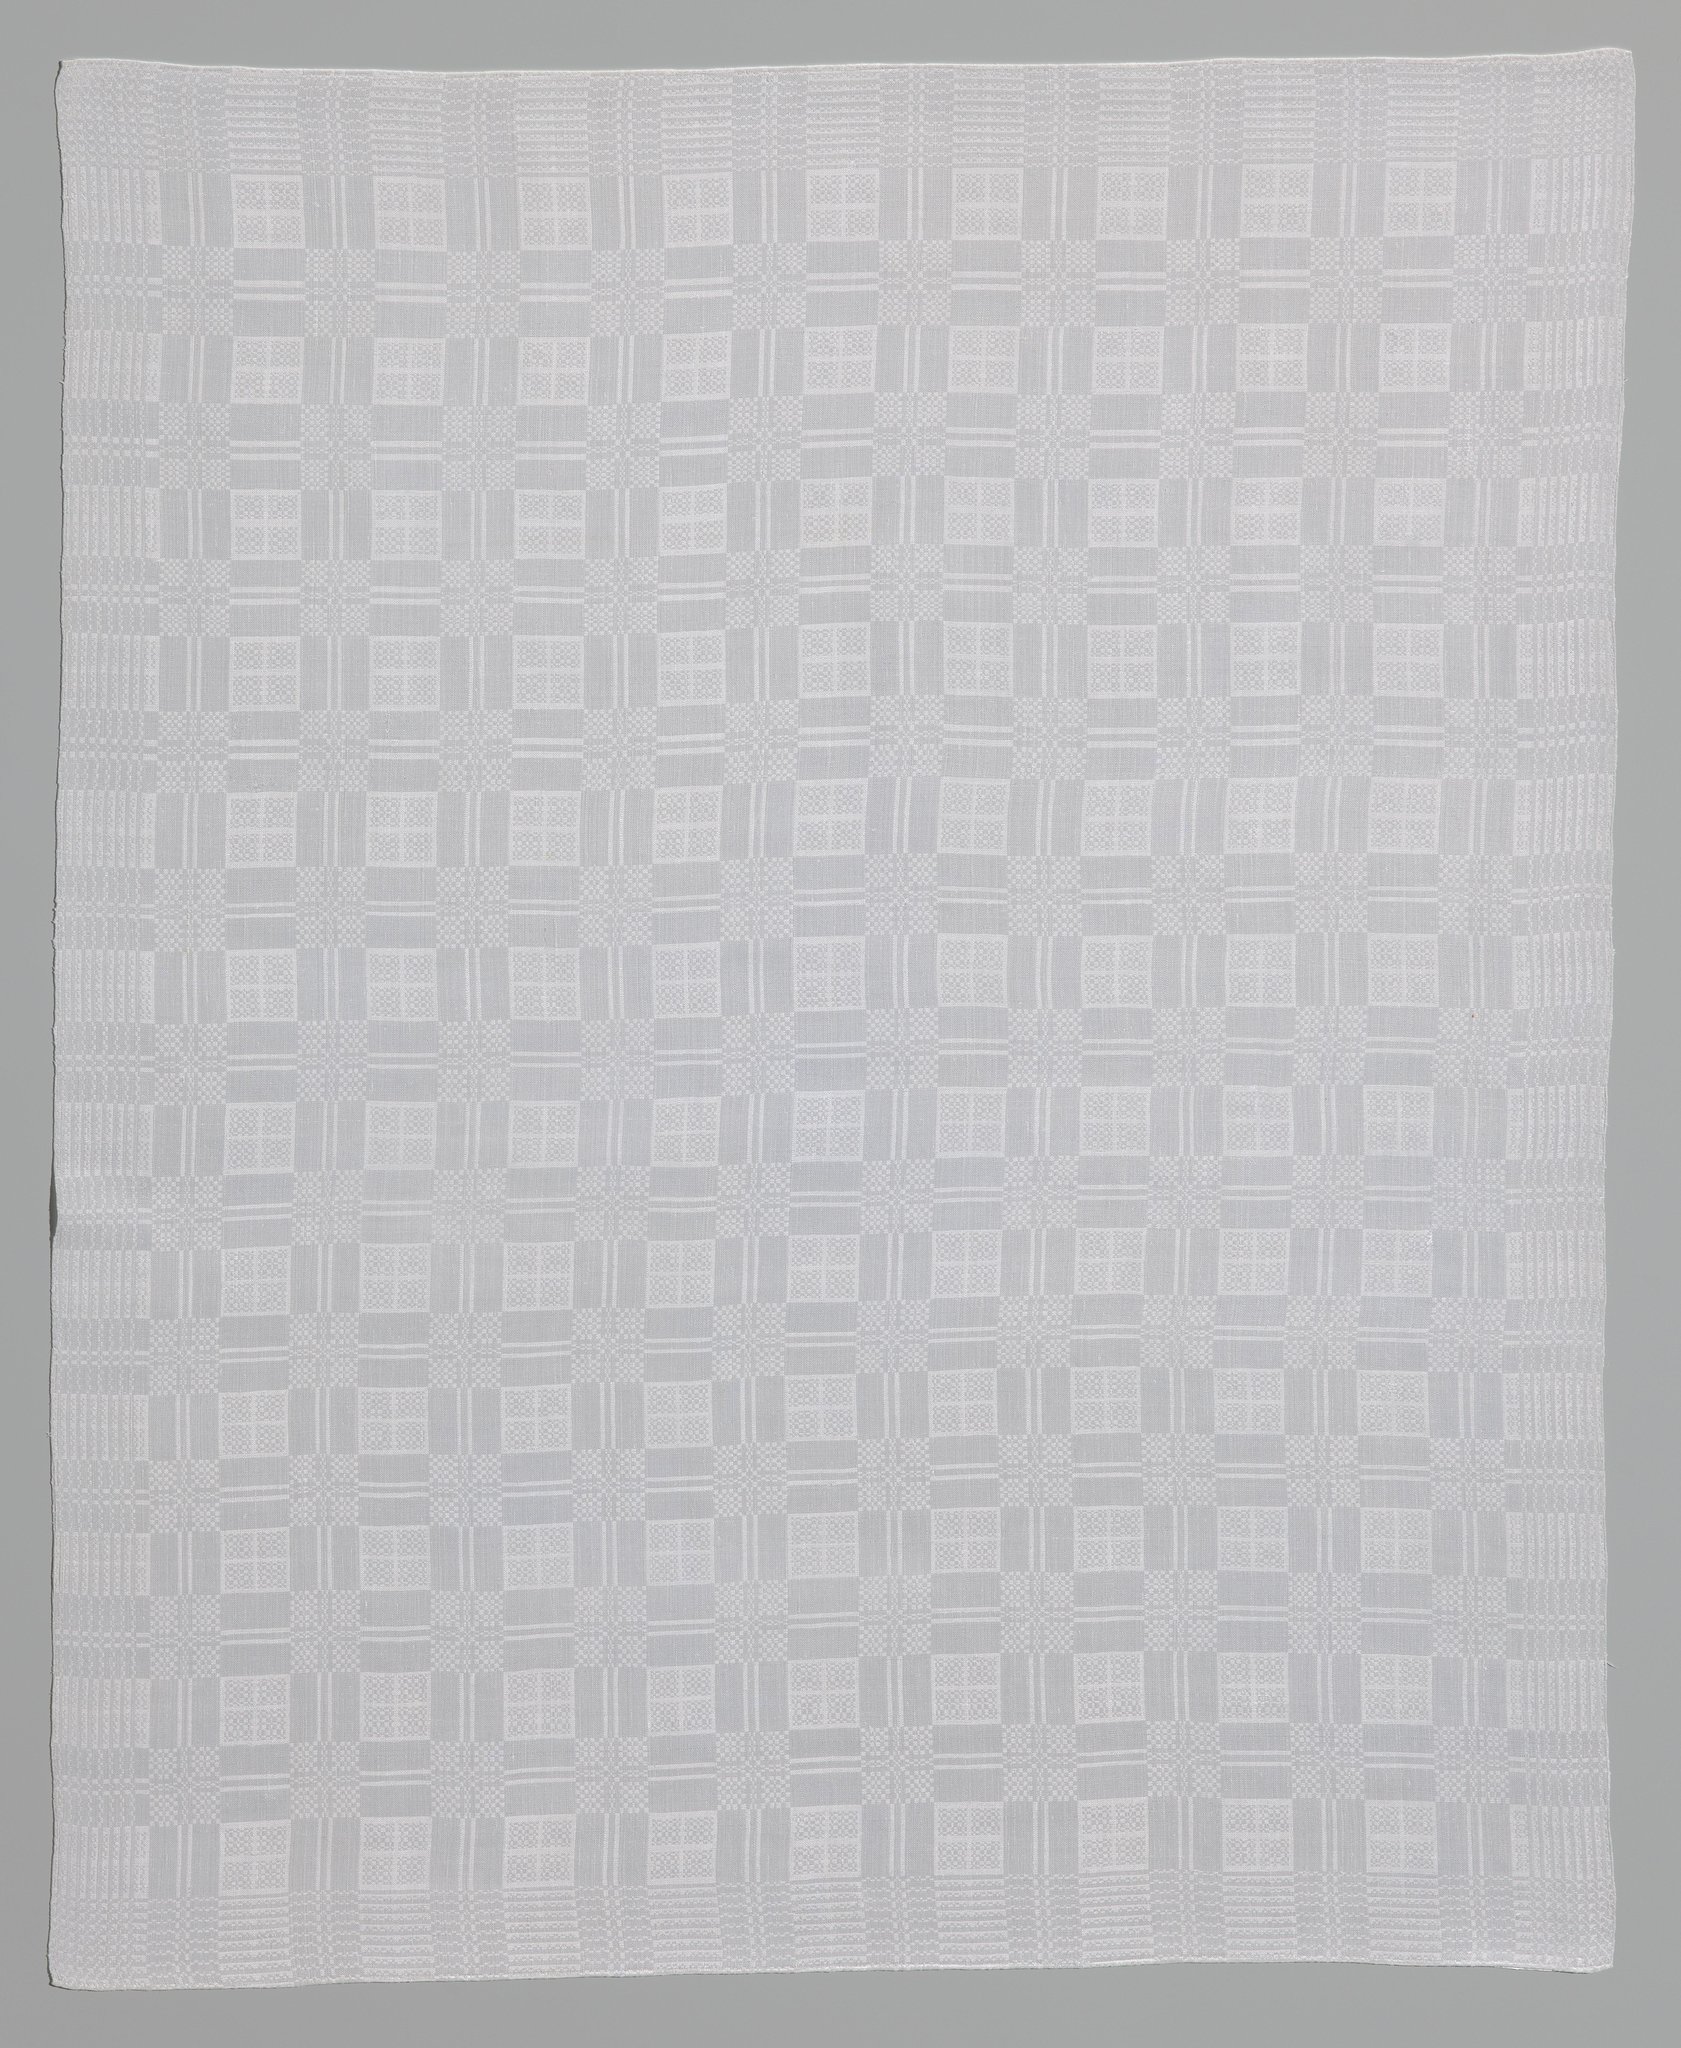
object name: napkin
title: Pellen in patroon 'kruiskeper'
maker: Anonymous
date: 1700-1799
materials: linen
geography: netherlands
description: Servet van wit linnen met een pellenpatroon in kruiskeper en randen rondom, merk kroon G 26.